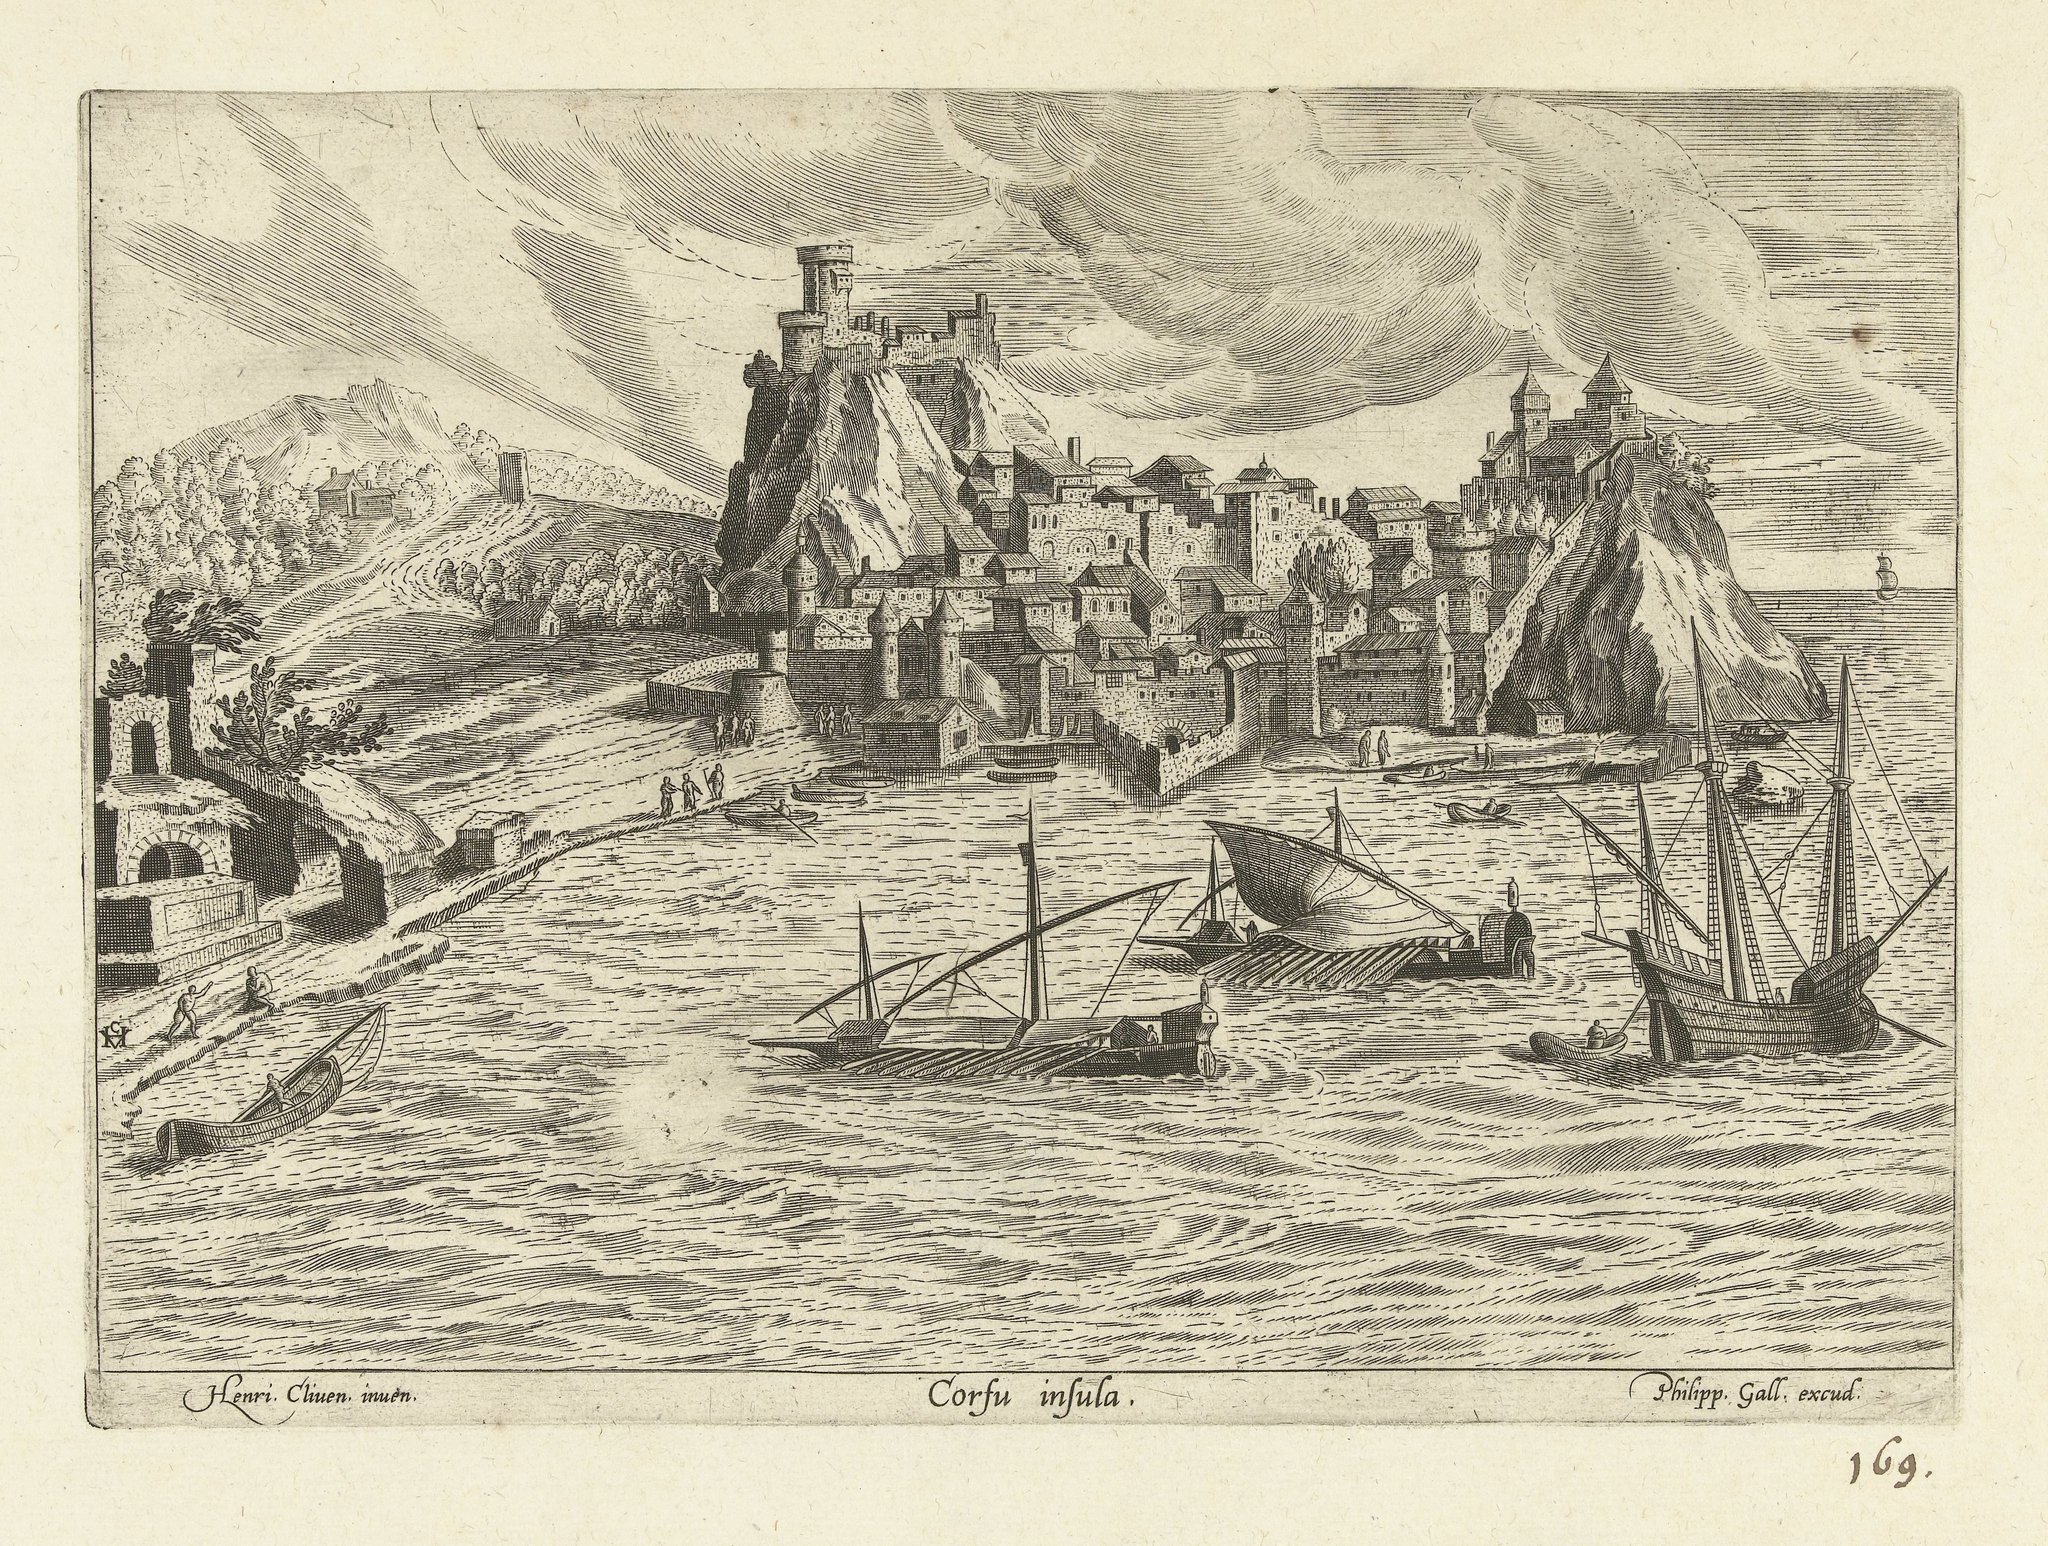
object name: print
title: Ruinarum varii prospectus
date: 1585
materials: paper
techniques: engraving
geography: antwerp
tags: city-view, and landscape with man-made constructions (+ city(-scape) with figures, staffage)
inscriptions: collector's mark: Lugt 2228, number: ‘169’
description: Gezicht op de haven van Corfu. Op de voorgrond enkele schepen. De prent is deel van een serie die verschillende plaatsen in het Middellandse Zeegebied afbeeldt.